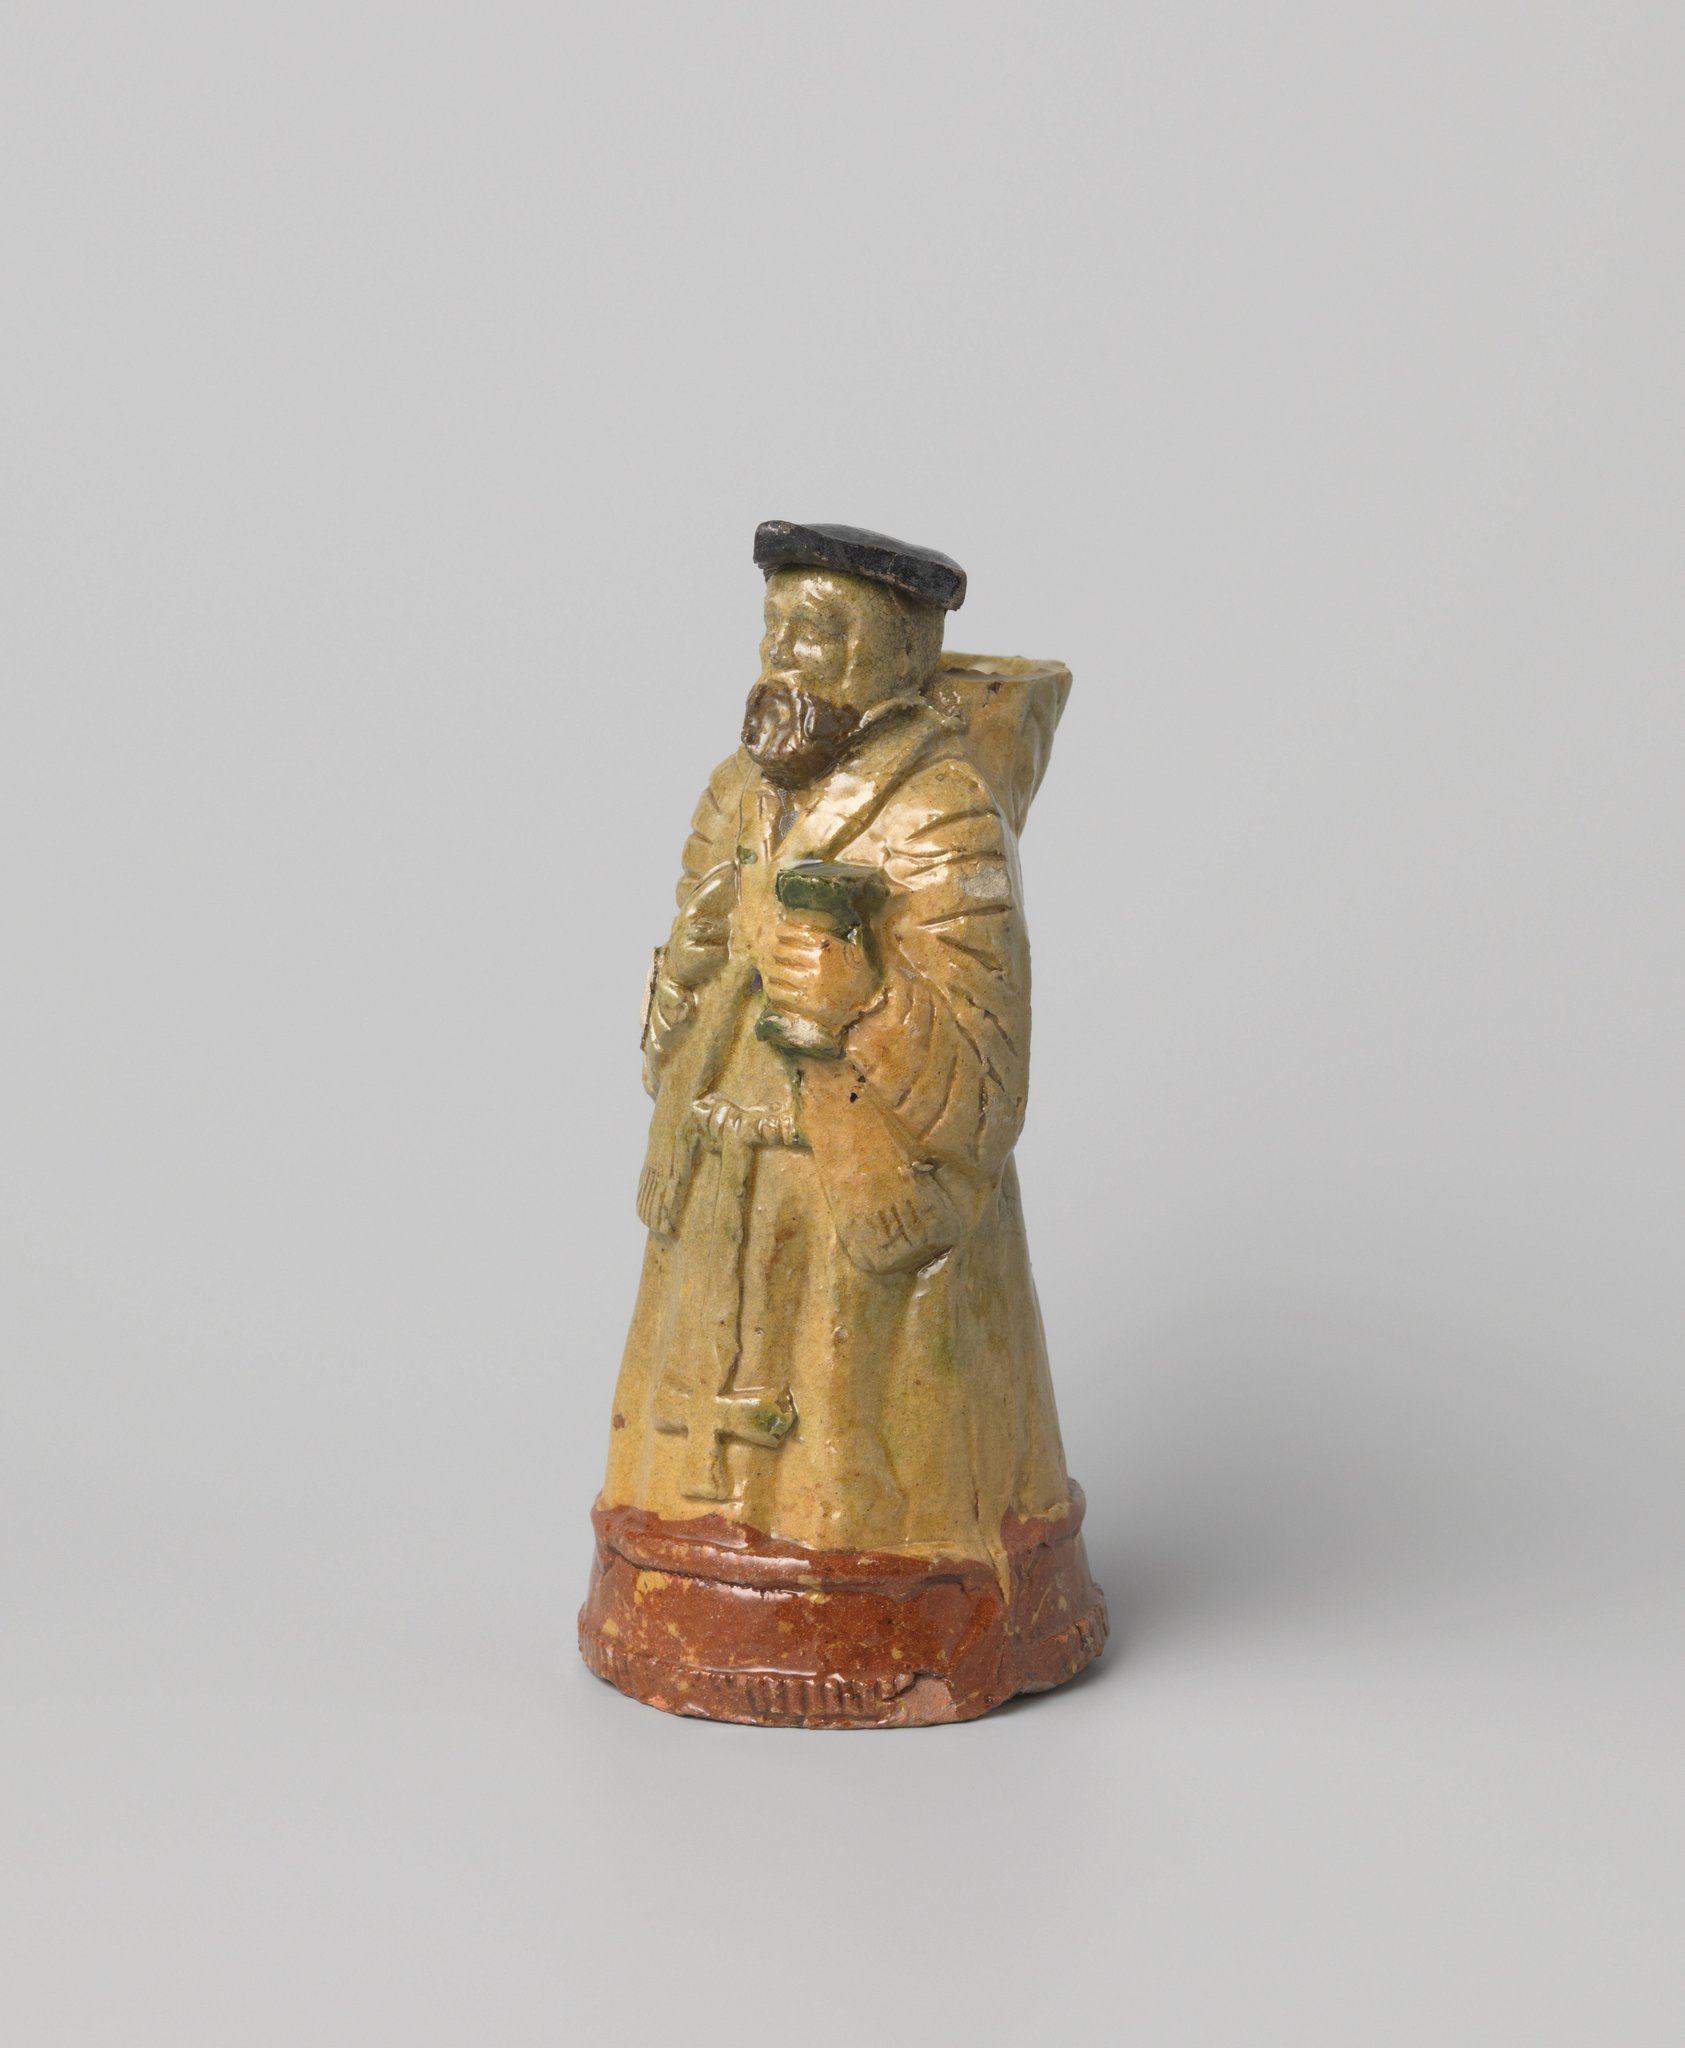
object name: cup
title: Monnikbeker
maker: Anonymous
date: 1600-1610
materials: earthenware, glaze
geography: netherlands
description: Beker van loodglazuuraardewerk, in de vorm van een priester. De beker is bedekt met groene en gele loodglazuur. De capuchon op de rug vormt de beker. De priester draagt een zwarte baret, een groenbruine baard en een groene miskelk in de linkerhand.